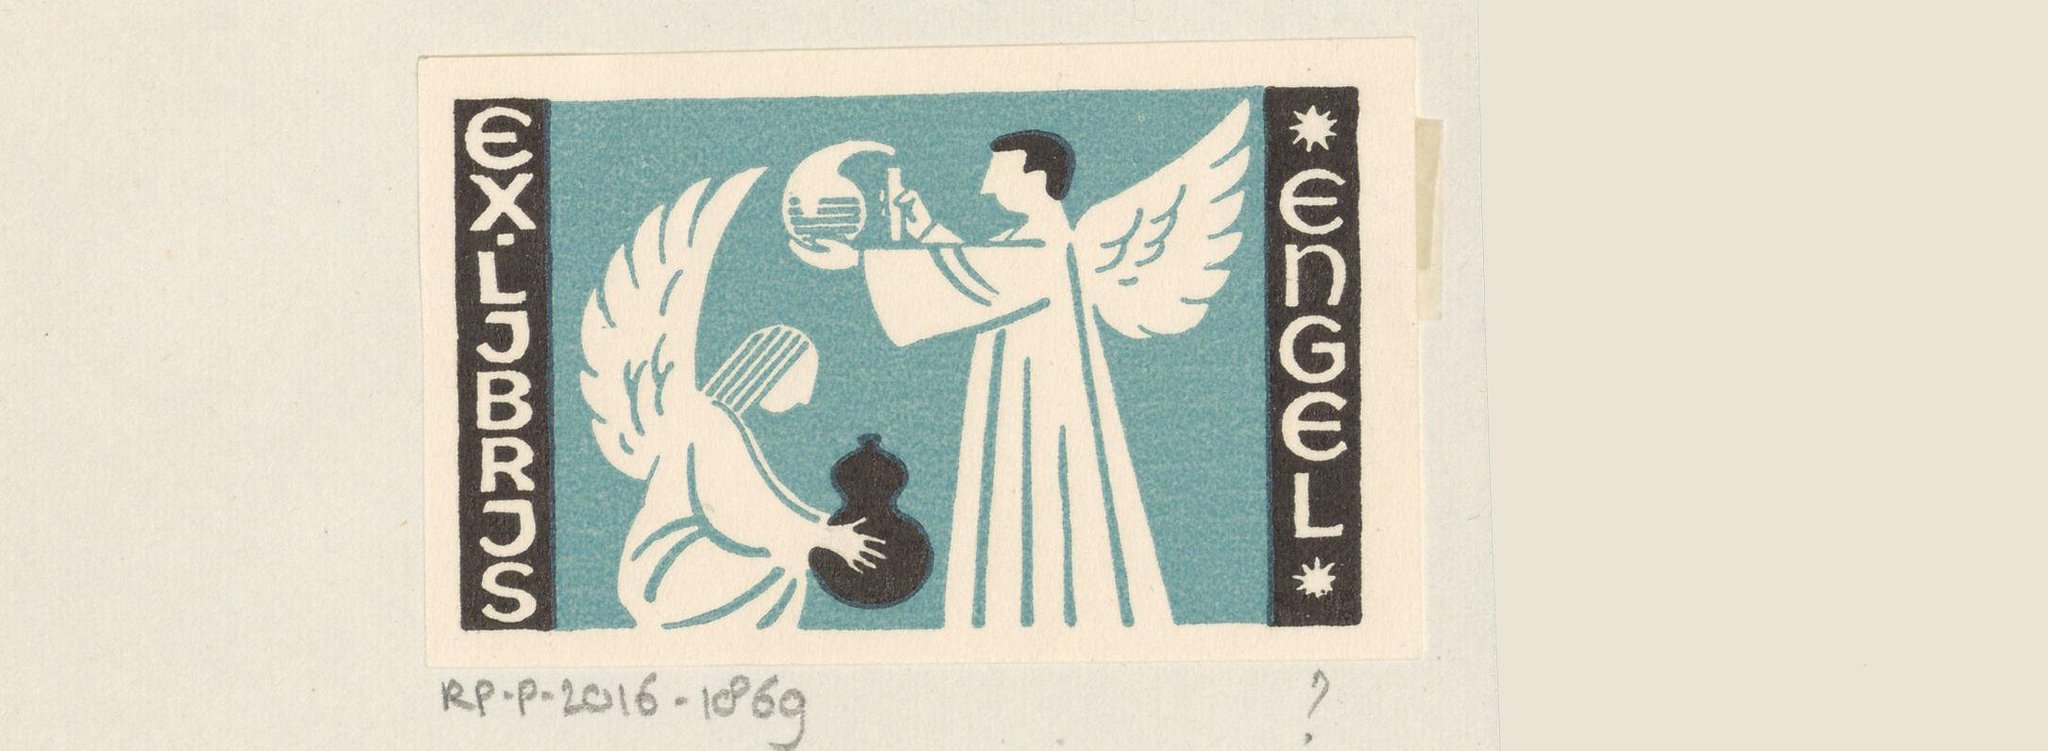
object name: bookplate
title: Ex libris van Engel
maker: poul petersen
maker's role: print maker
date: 1900-1999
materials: paper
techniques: printing block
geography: denmark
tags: chemistry, angels